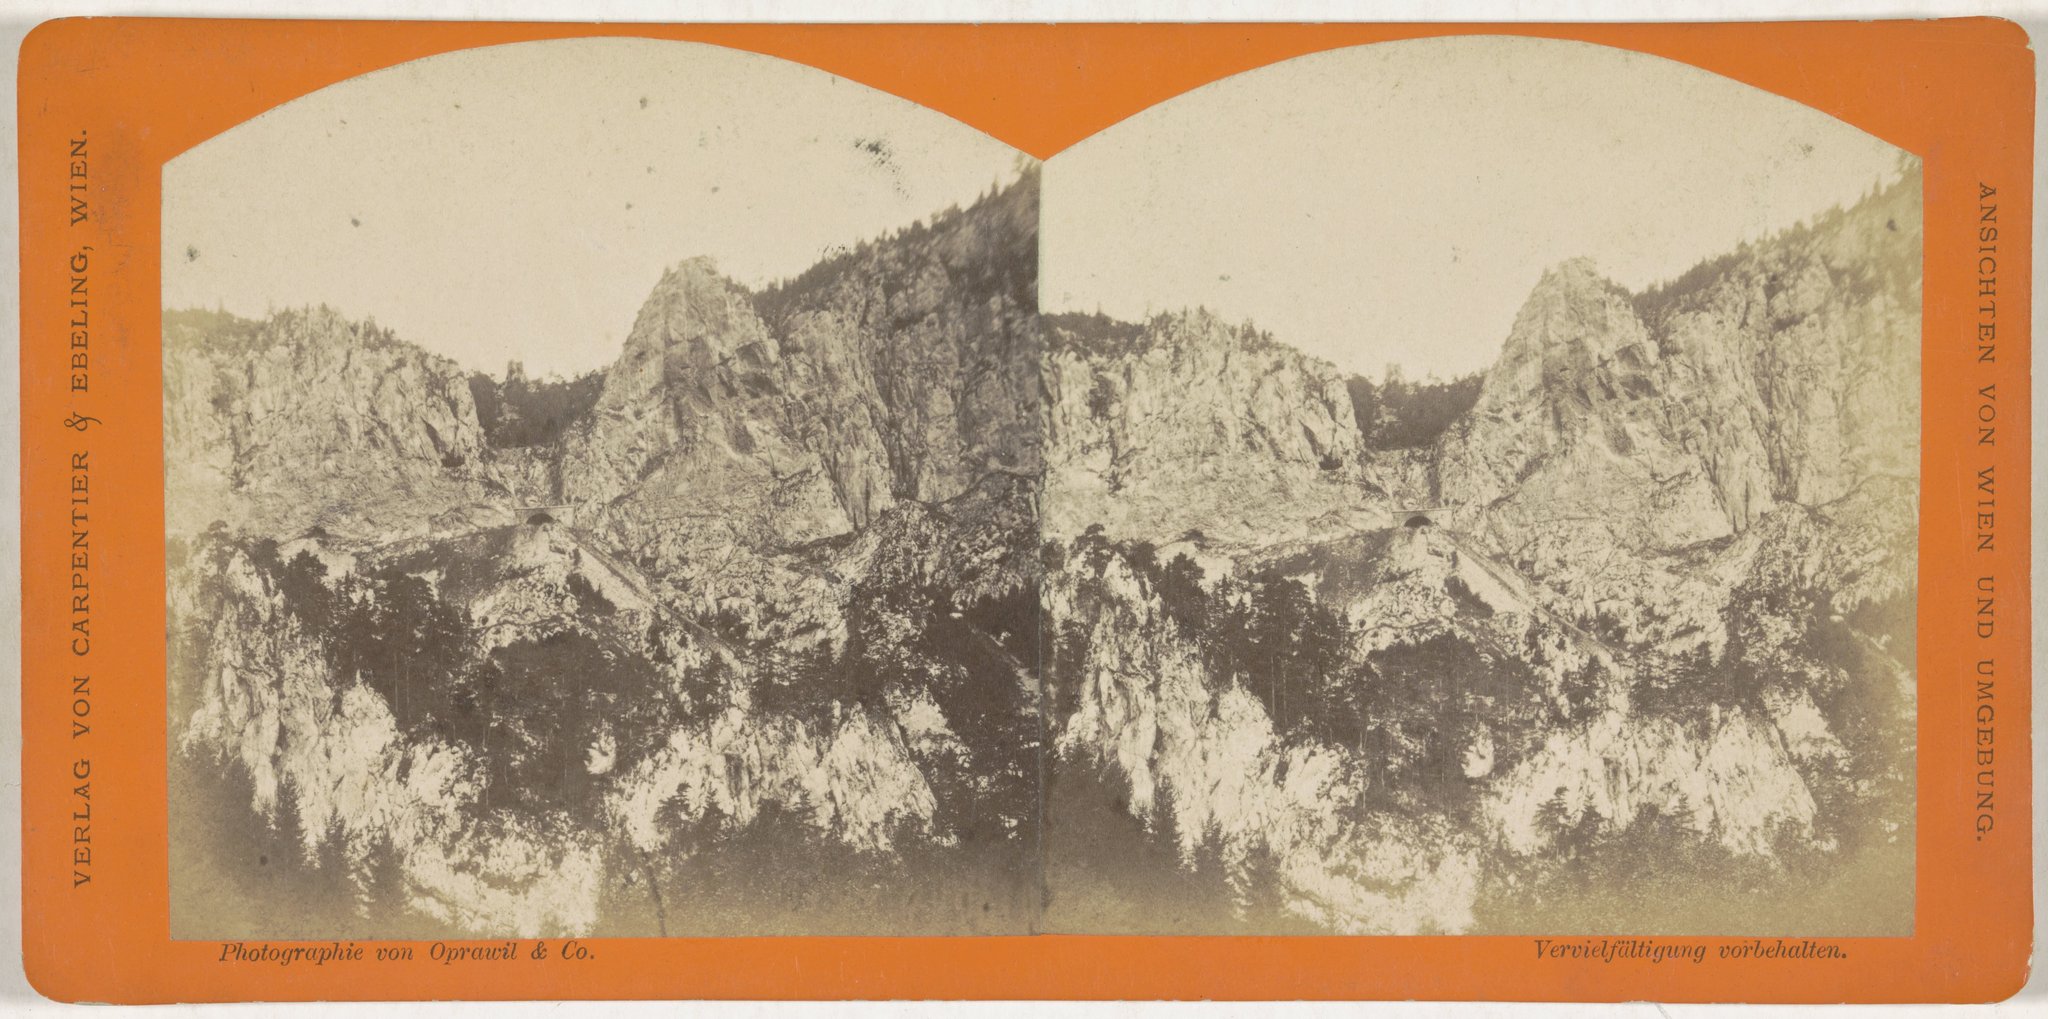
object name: stereograph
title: Semmering. Weinzettelwand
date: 1868-1890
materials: cardboard, paper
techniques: albumen print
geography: adlitzgraben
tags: railway, train, mountains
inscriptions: inscription: ‘Vervielfältigung vorbehalten.’